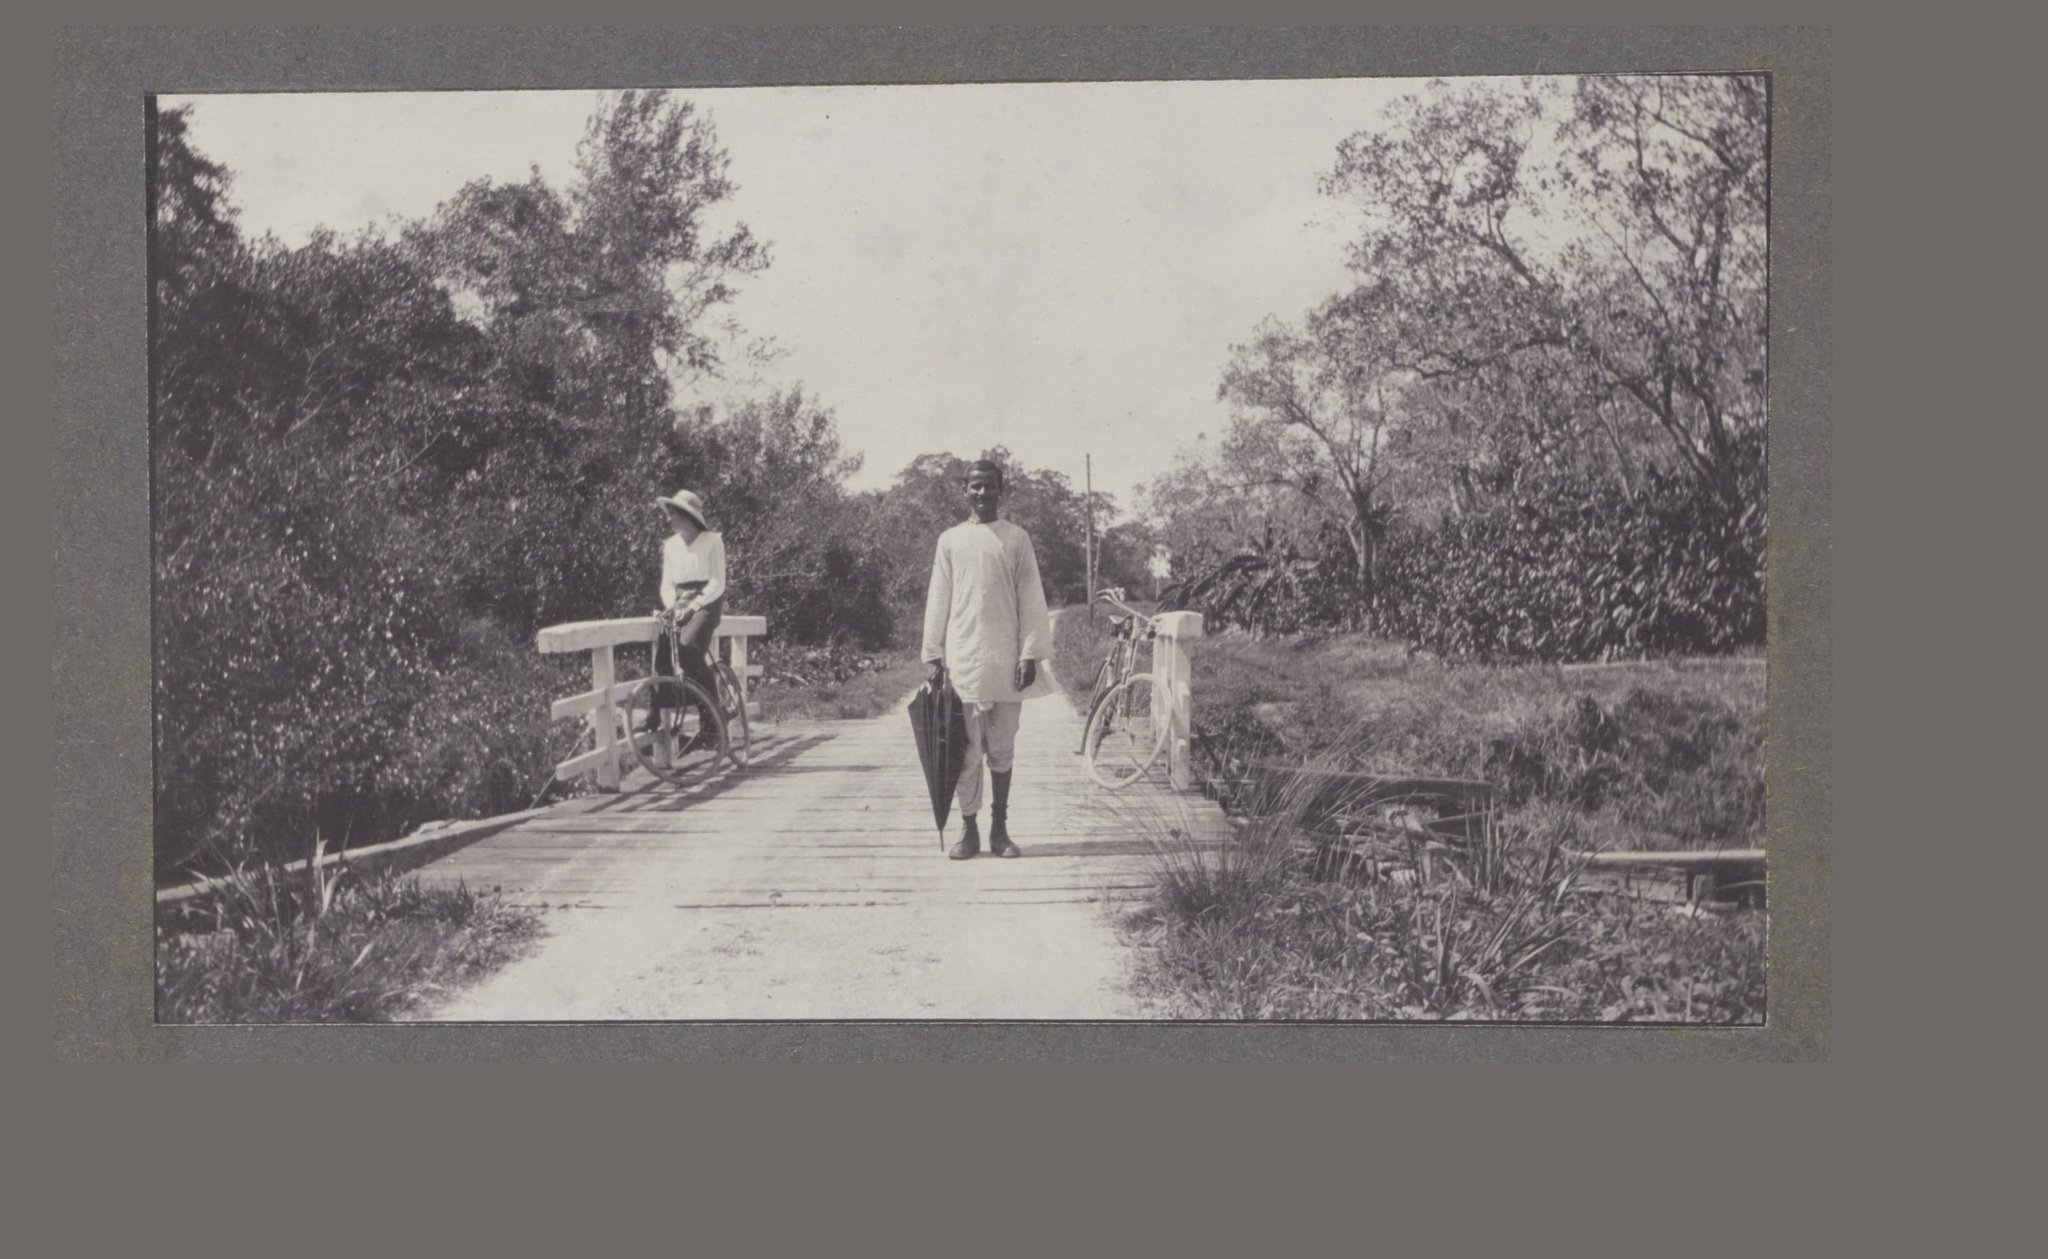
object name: photograph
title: Hindostaanse man met parasol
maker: andries augustus boom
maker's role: amateurfotograaf, handelaar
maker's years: 1878-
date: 1911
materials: photographic support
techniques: photography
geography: suriname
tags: landscapes in tropical and sub-tropical regions, suriname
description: Een Hindostaanse man met een parasol poseert op een brug, verder naar achteren Maria Gonggrijp op de fiets en een tweede fiets, 1911. Onderweg naar Plantage Morgenstond. Onderdeel van het fotoalbum over het leven van de familie Gonggrijp in Suriname rond 1912.